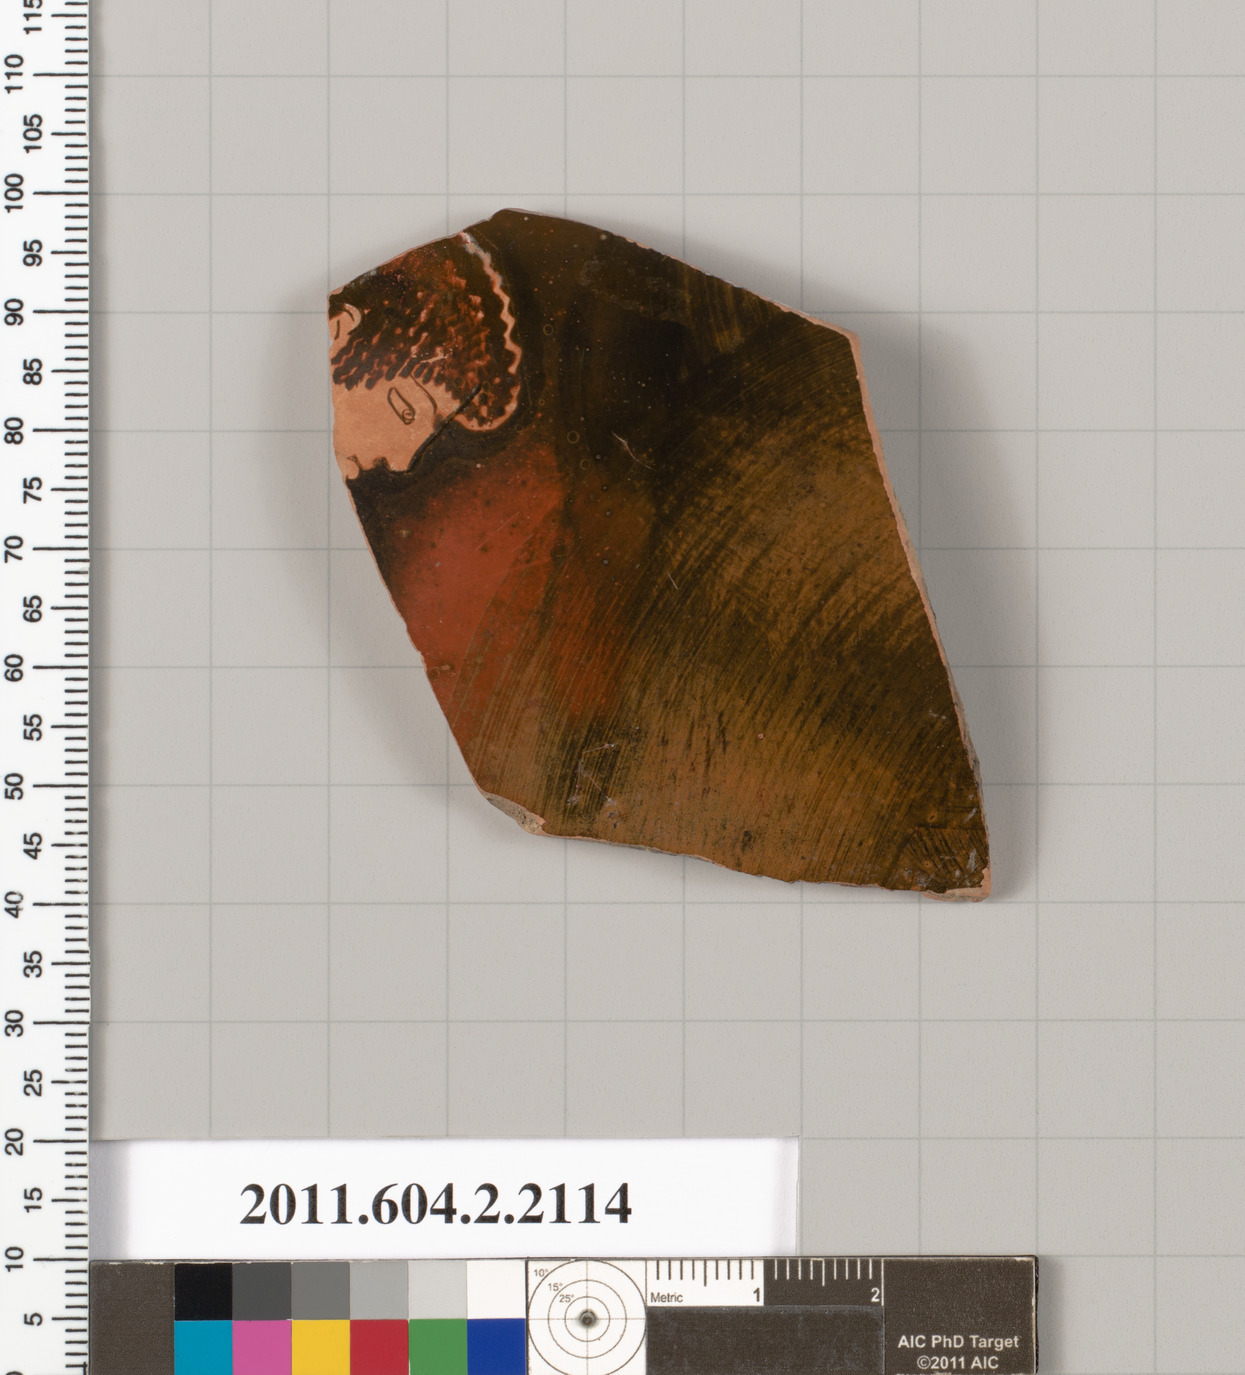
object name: kalpis fragment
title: Terracotta fragment of a hydria: kalpis (water jar)?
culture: greek, attic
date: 490-470 BCE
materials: terracotta